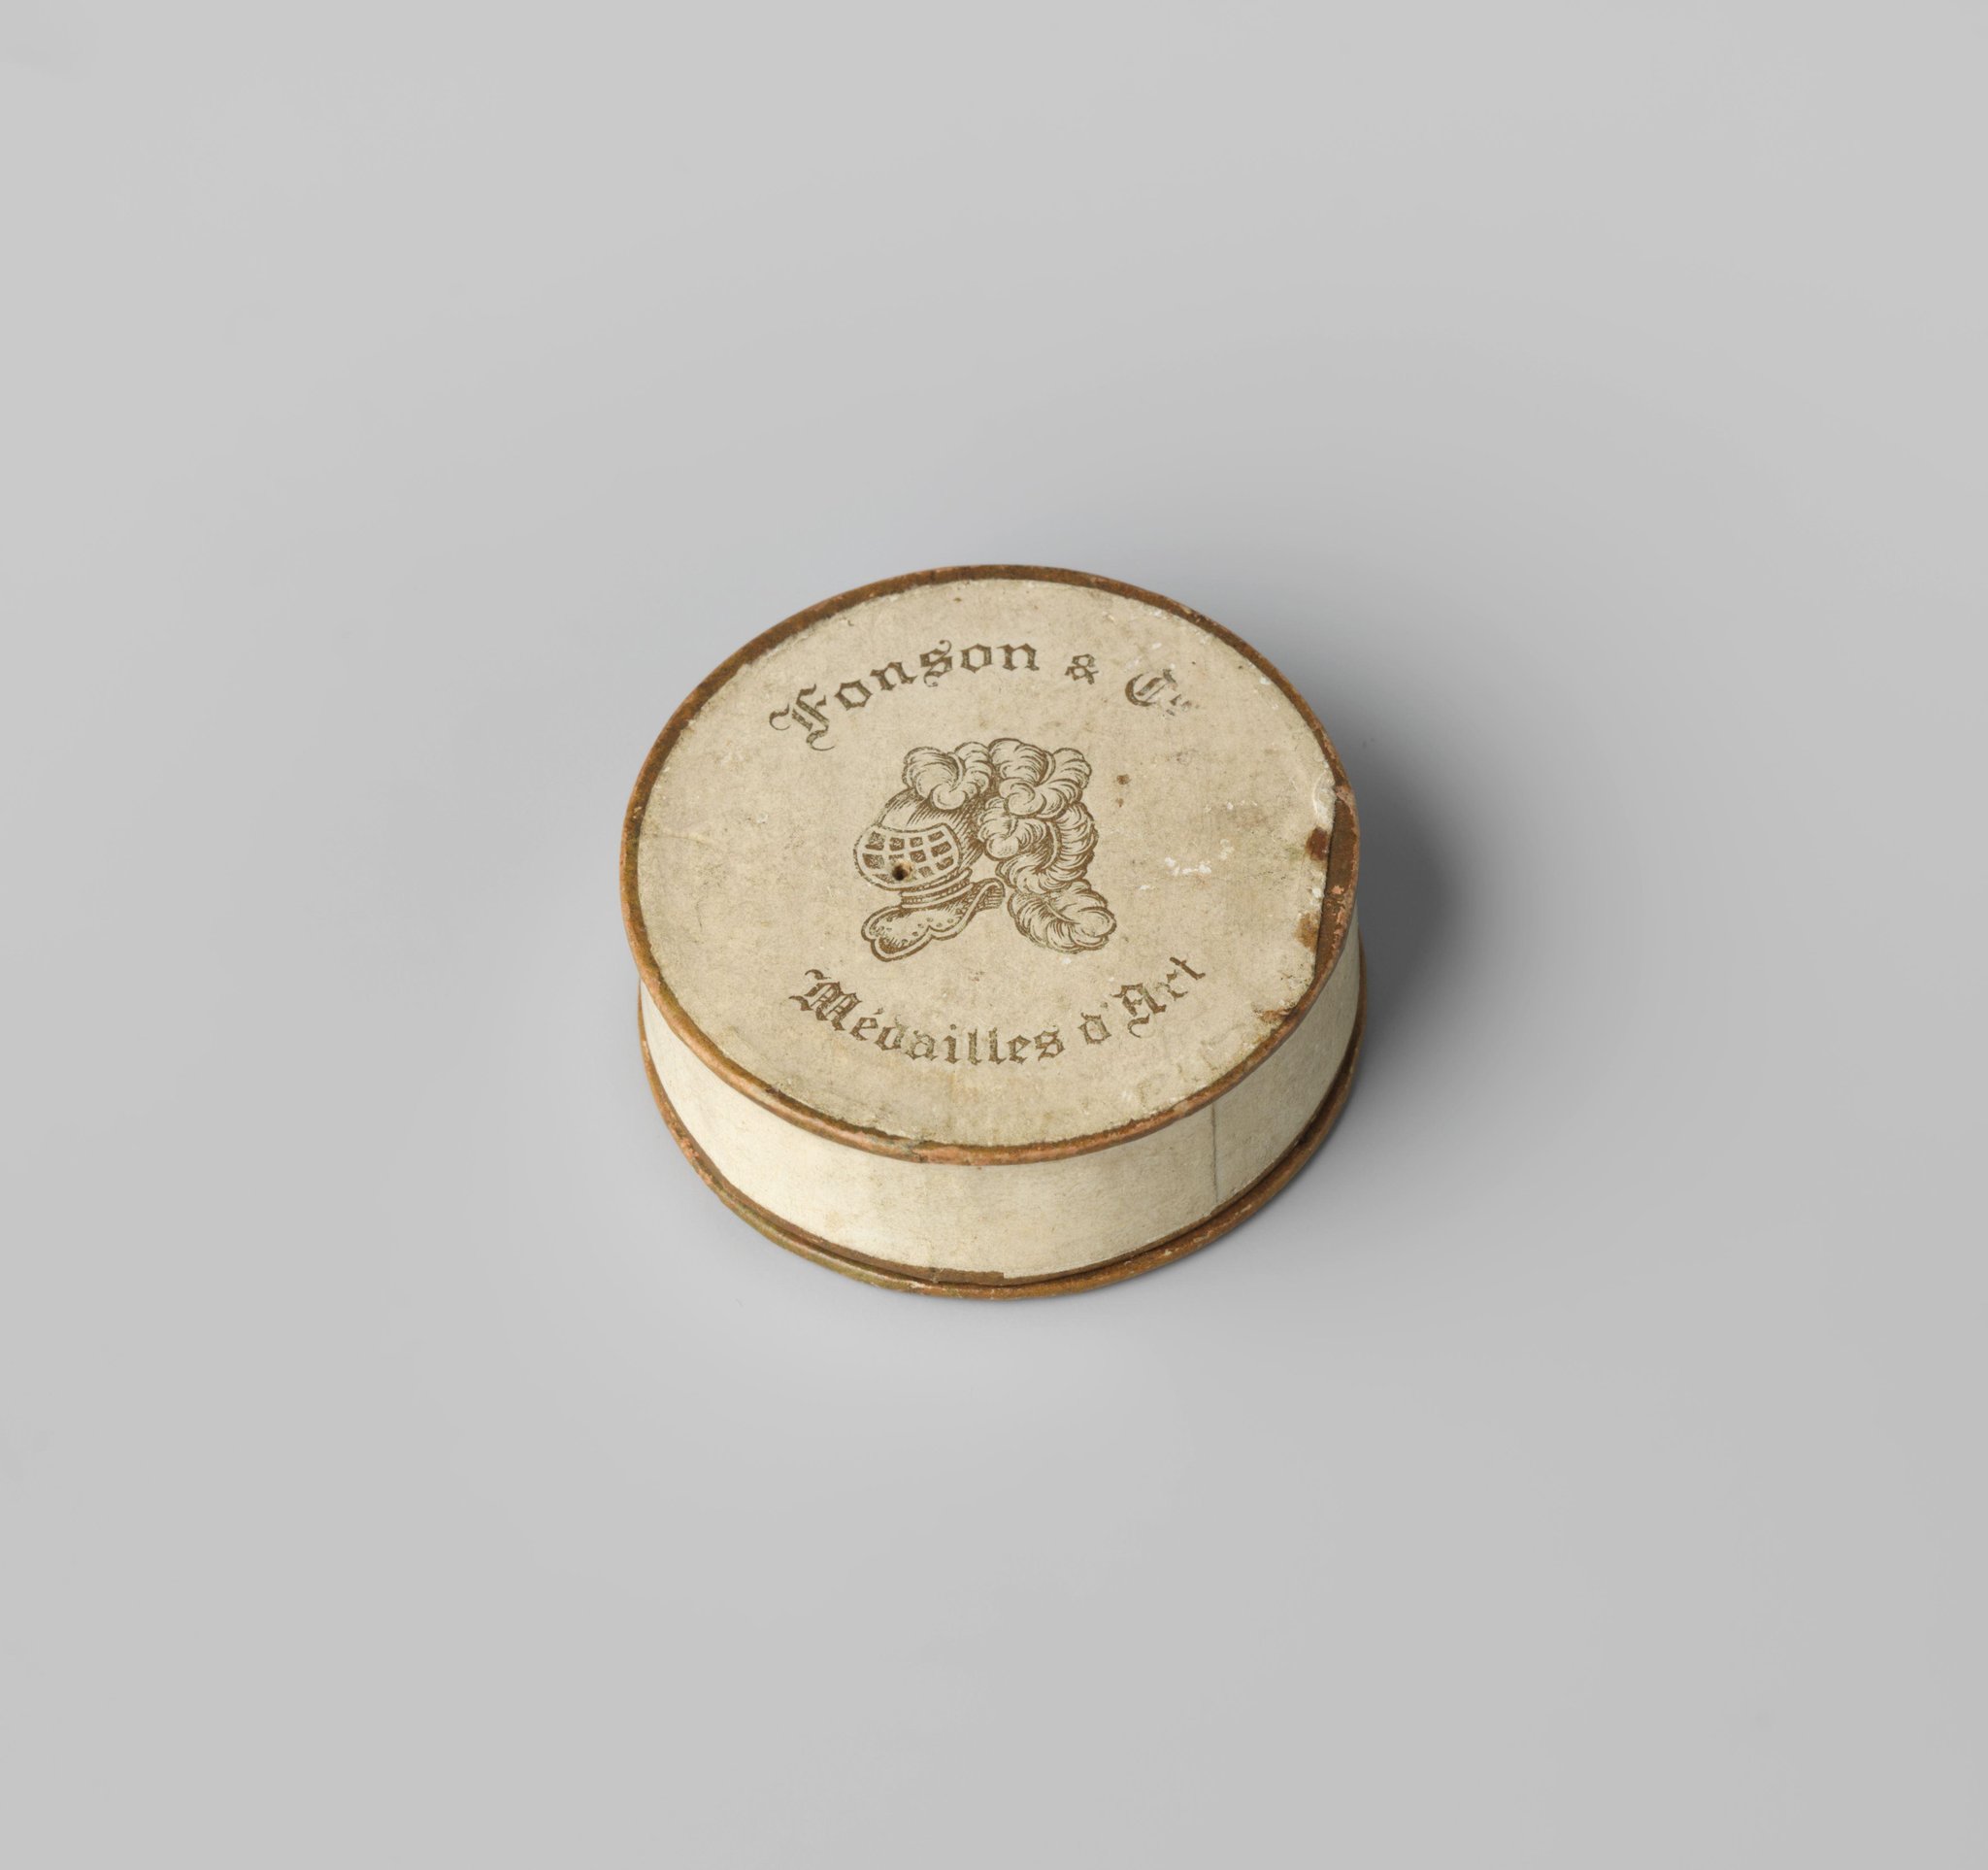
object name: insignia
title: Doosje voor een draagteken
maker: jean lecroart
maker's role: medailleur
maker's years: 1883-1967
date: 1910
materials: cardboard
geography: brussels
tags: the hague, sculptor, bart van hove, brussels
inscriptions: inscription: ‘JURY EXPOSITION DE BRUXELLES 1910’, inscription: ‘FONSON .&c;. BRUX’, signature: ‘J. LECROART’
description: Rond kartonnen doosje behorend bij het draagteken uitgereikt aan Bart van Hove, een van de juryleden van de Wereldtentoonstelling te Brussel, 1910